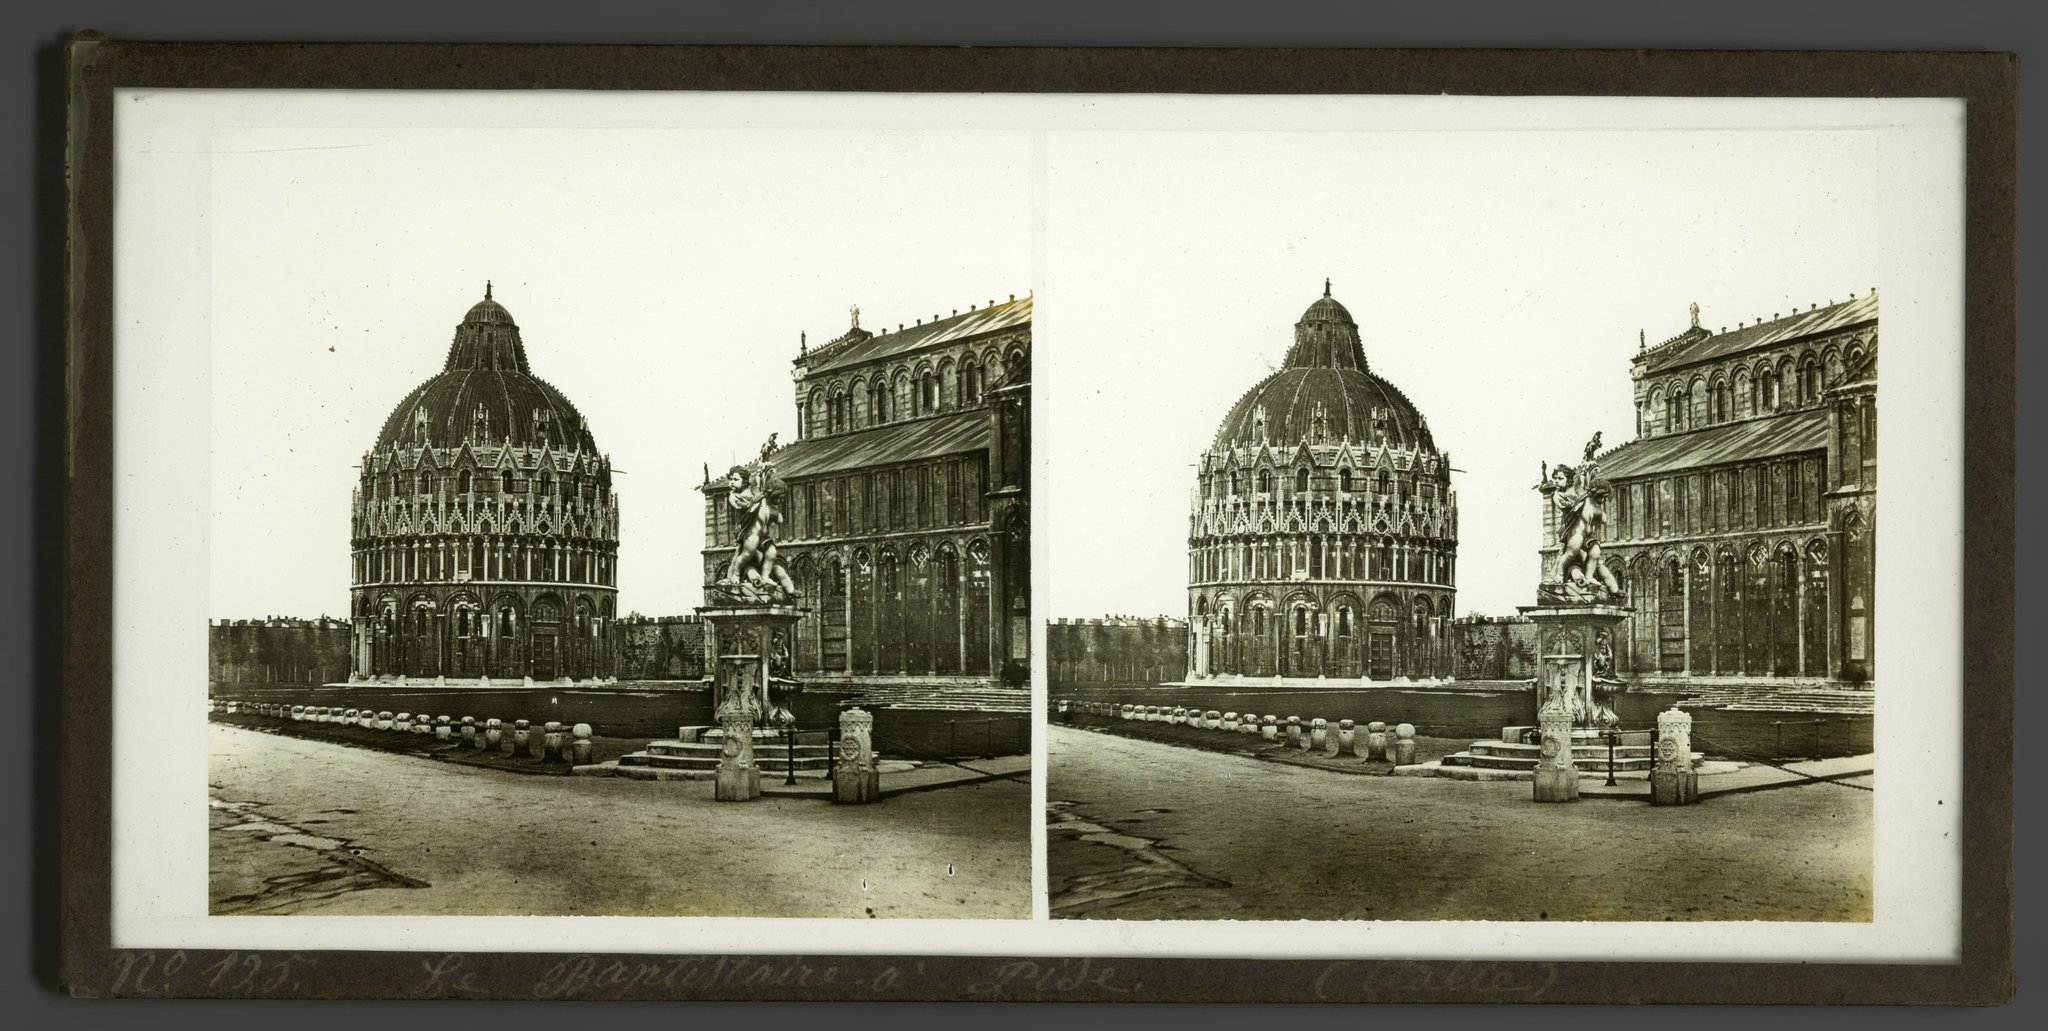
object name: stereoscopic photograph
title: Gezicht op het Baptisterium in Pisa, Italië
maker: Anonymous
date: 1856-1890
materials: glass, paper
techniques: slide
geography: pisa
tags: parts of church exterior and annexes: chapel - qq - small church, chapel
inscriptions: annotation: ‘No. 125. Le Baptistère à Pise. (Italie.)’